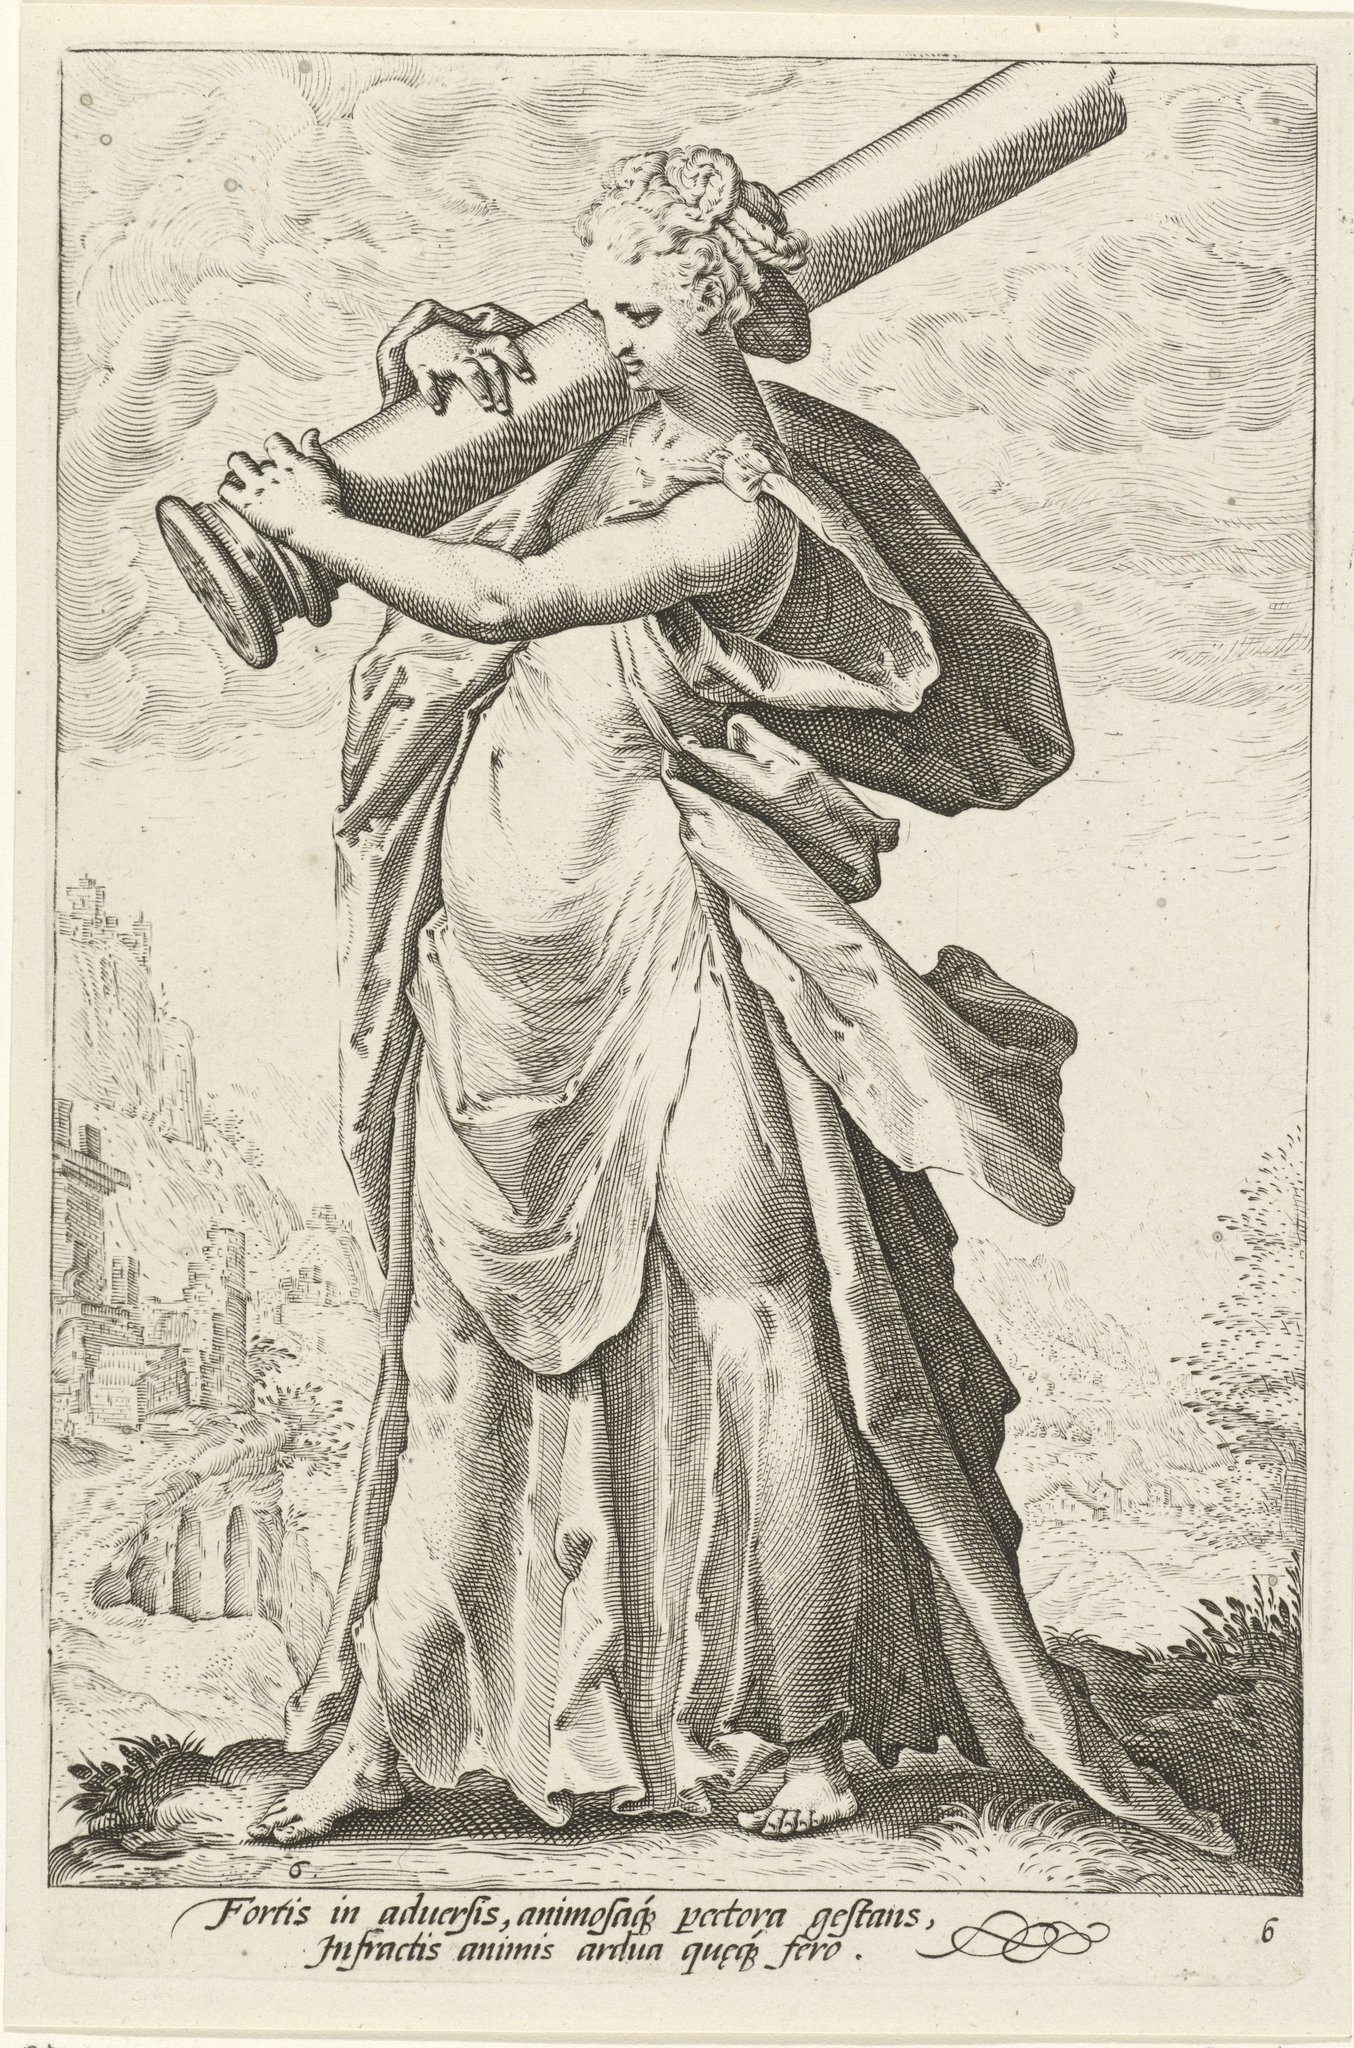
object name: print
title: De deugden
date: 1585-1589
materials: paper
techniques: engraving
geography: amsterdam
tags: fortitude, 'fortitudo' ~ one of the four cardinal virtues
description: De gepersonifieerde Kracht; een vrouwenfiguur met een zuil over haar rechter schouder. Op de achtergrond een heuvellandschap.